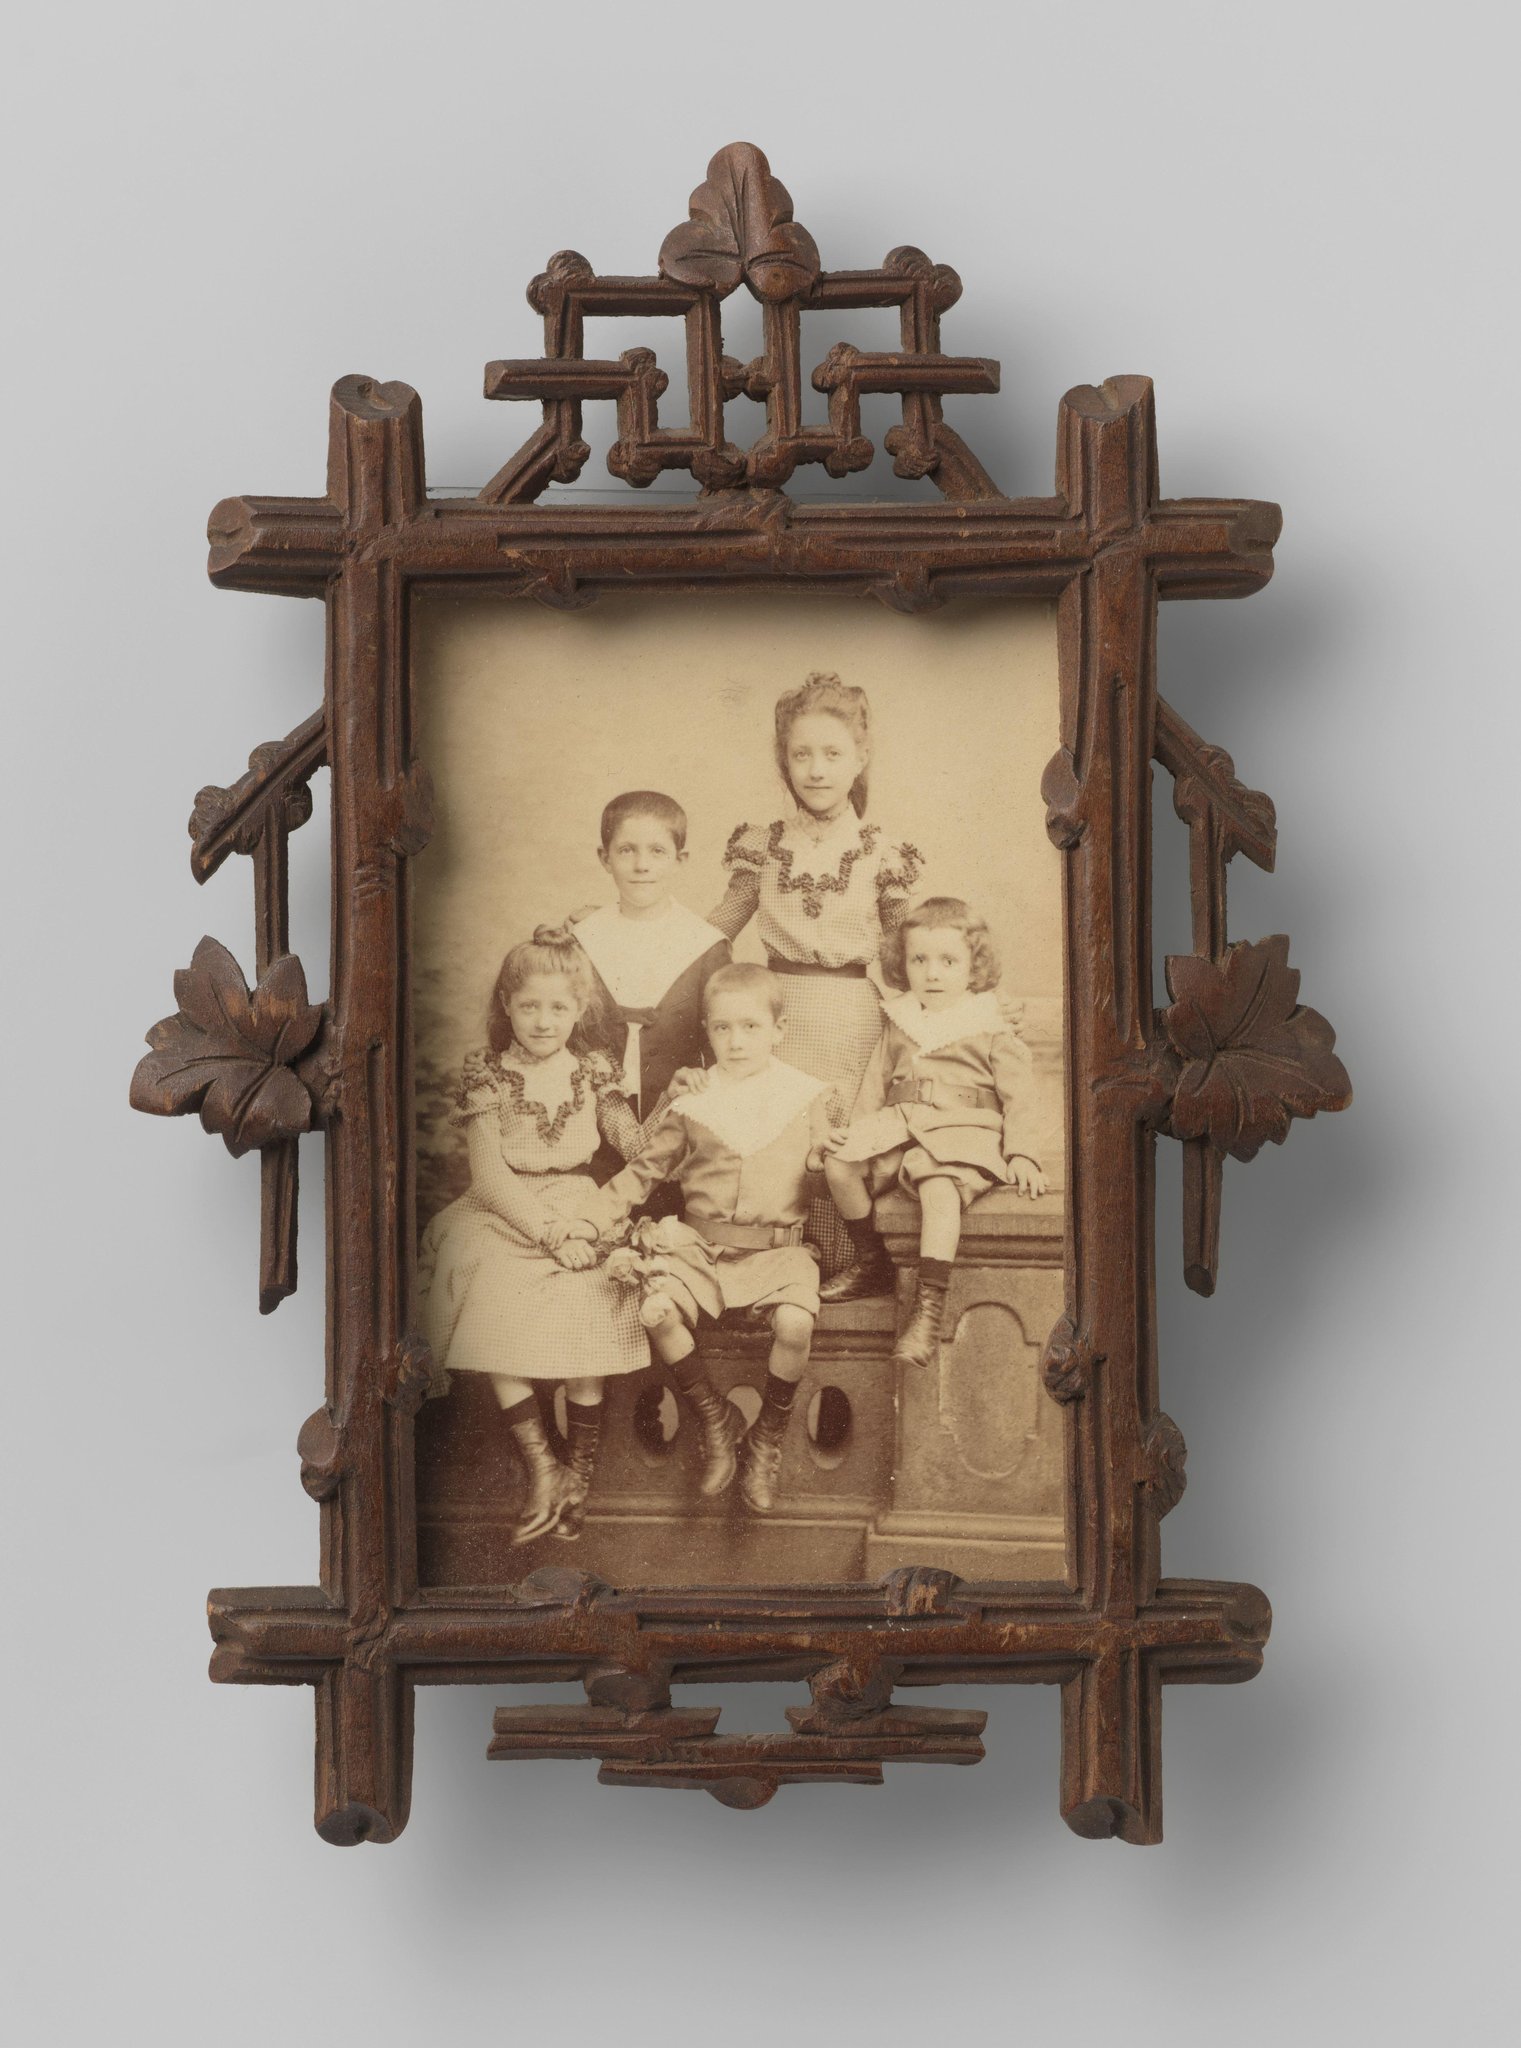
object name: frame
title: Familieportret van vijf onbekende kinderen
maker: Anonymous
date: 1880-1900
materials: glass, metal, paper, wood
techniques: albumen print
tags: child, anonymous historical person portrayed